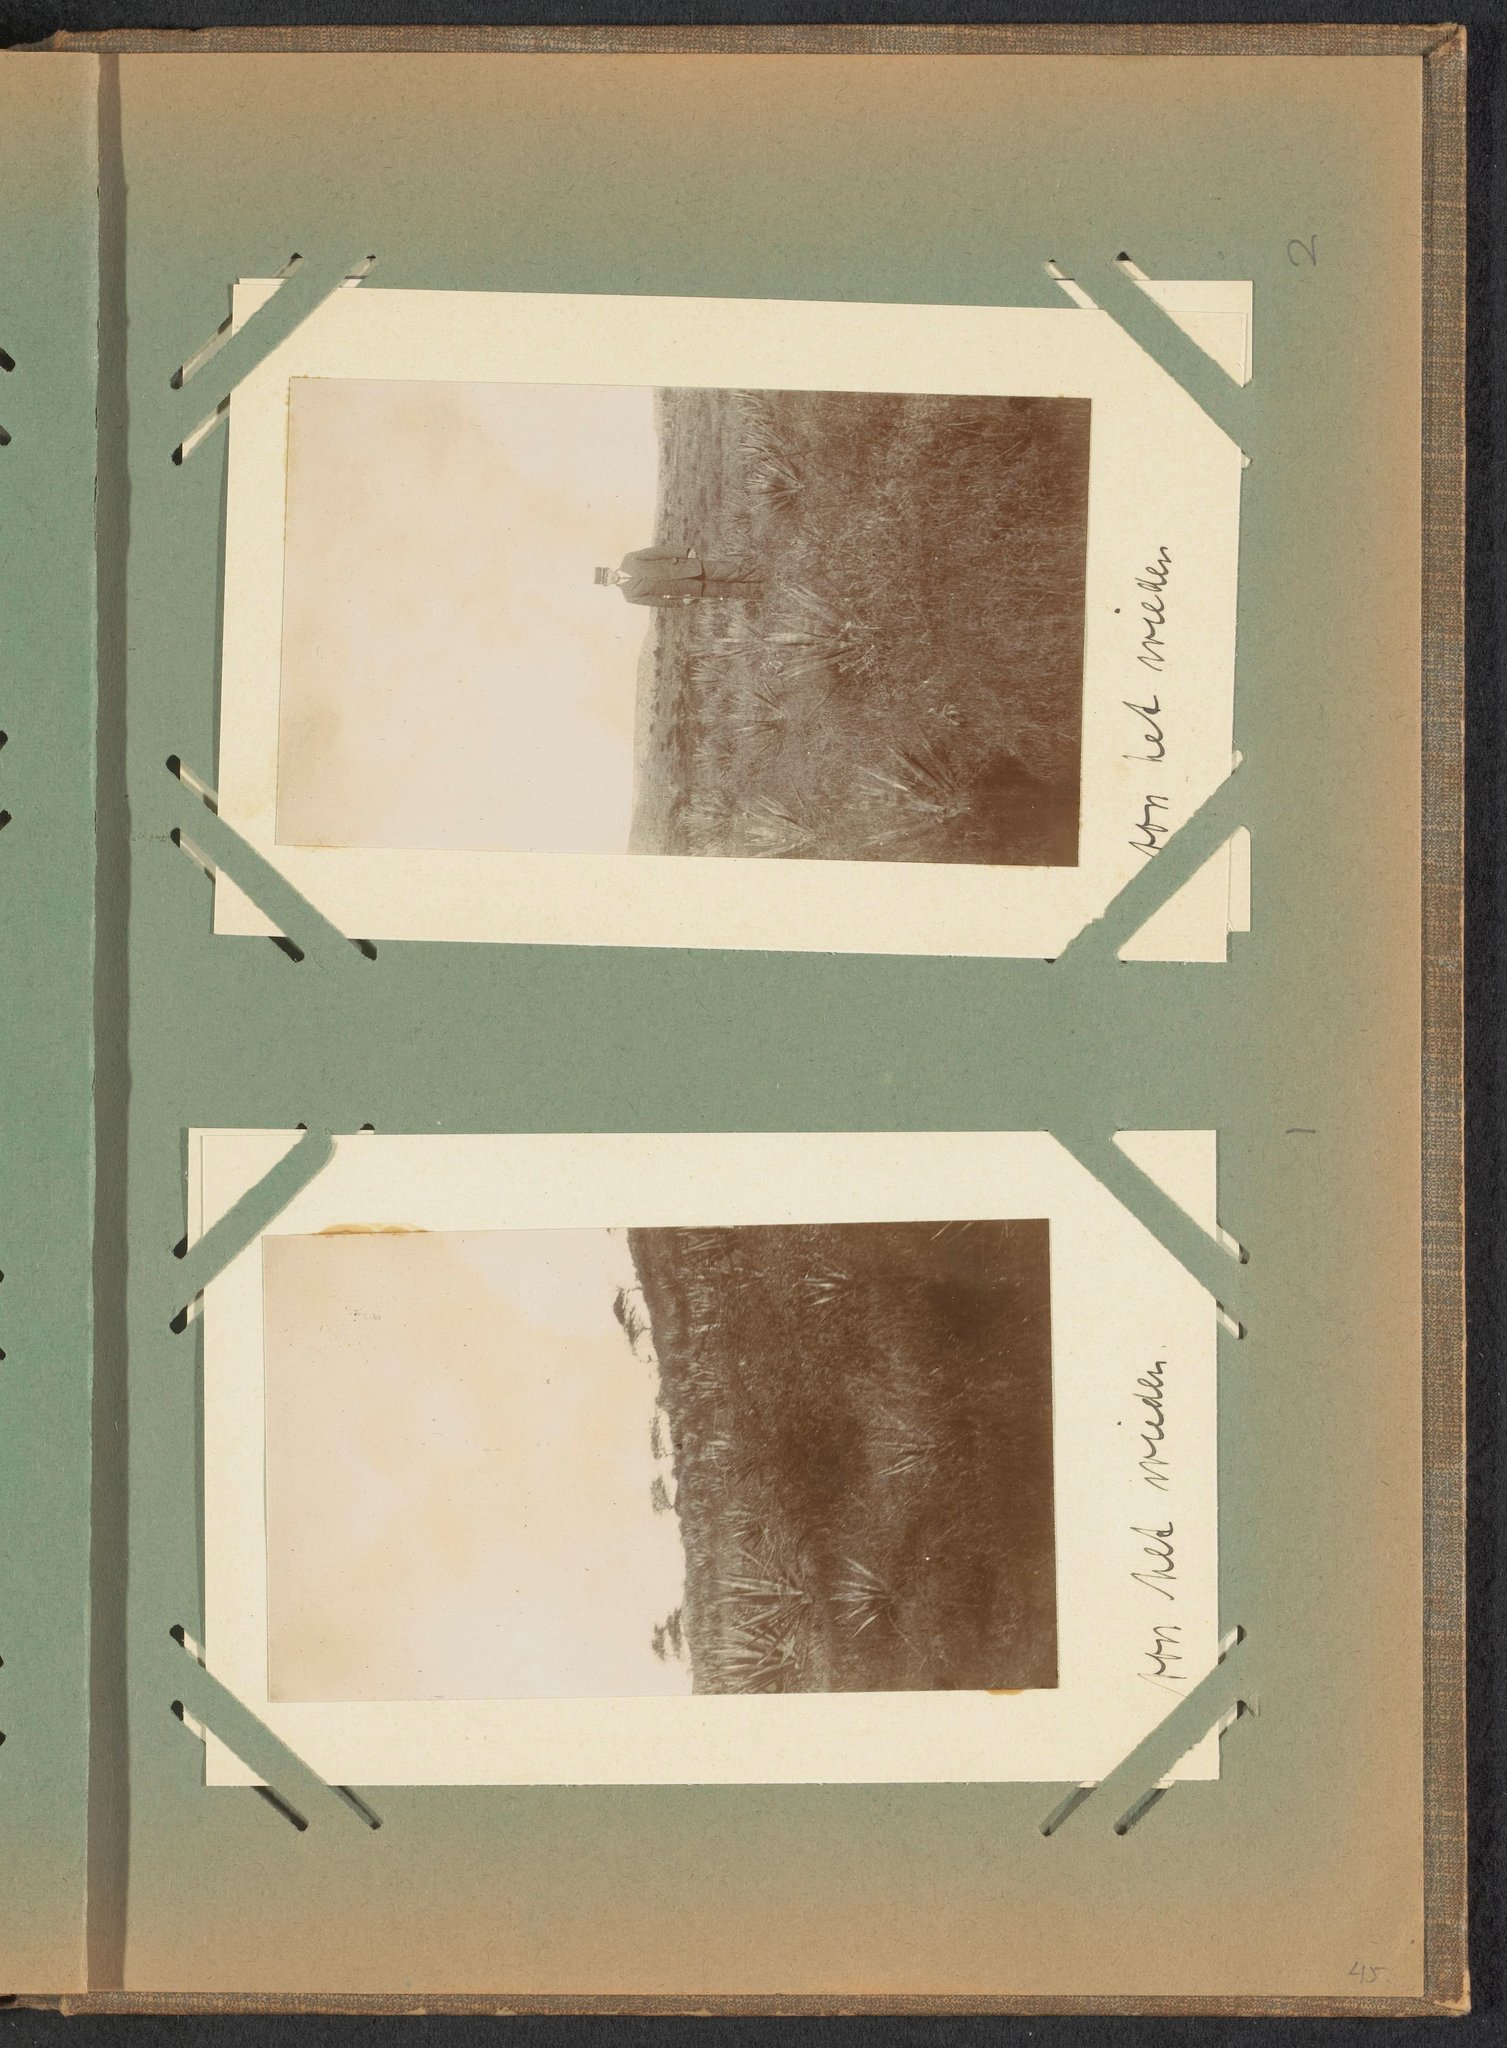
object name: photograph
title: voor het wieden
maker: Anonymous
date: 1912-1913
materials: paper, photographic support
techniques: gelatin silver print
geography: curacao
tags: plantation, (non-fruit) products of plants or trees: sisal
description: Ongewied veld met sisalplanten (in of vóór 1913) op Plantage Mount Pleasant op Curaçao. Onderdeel van het fotoalbum uit ca. 1912-1913 met 92 foto's van de plantages Peperpot en Dordrecht in Suriname en Mount Pleasant op Curaçao.